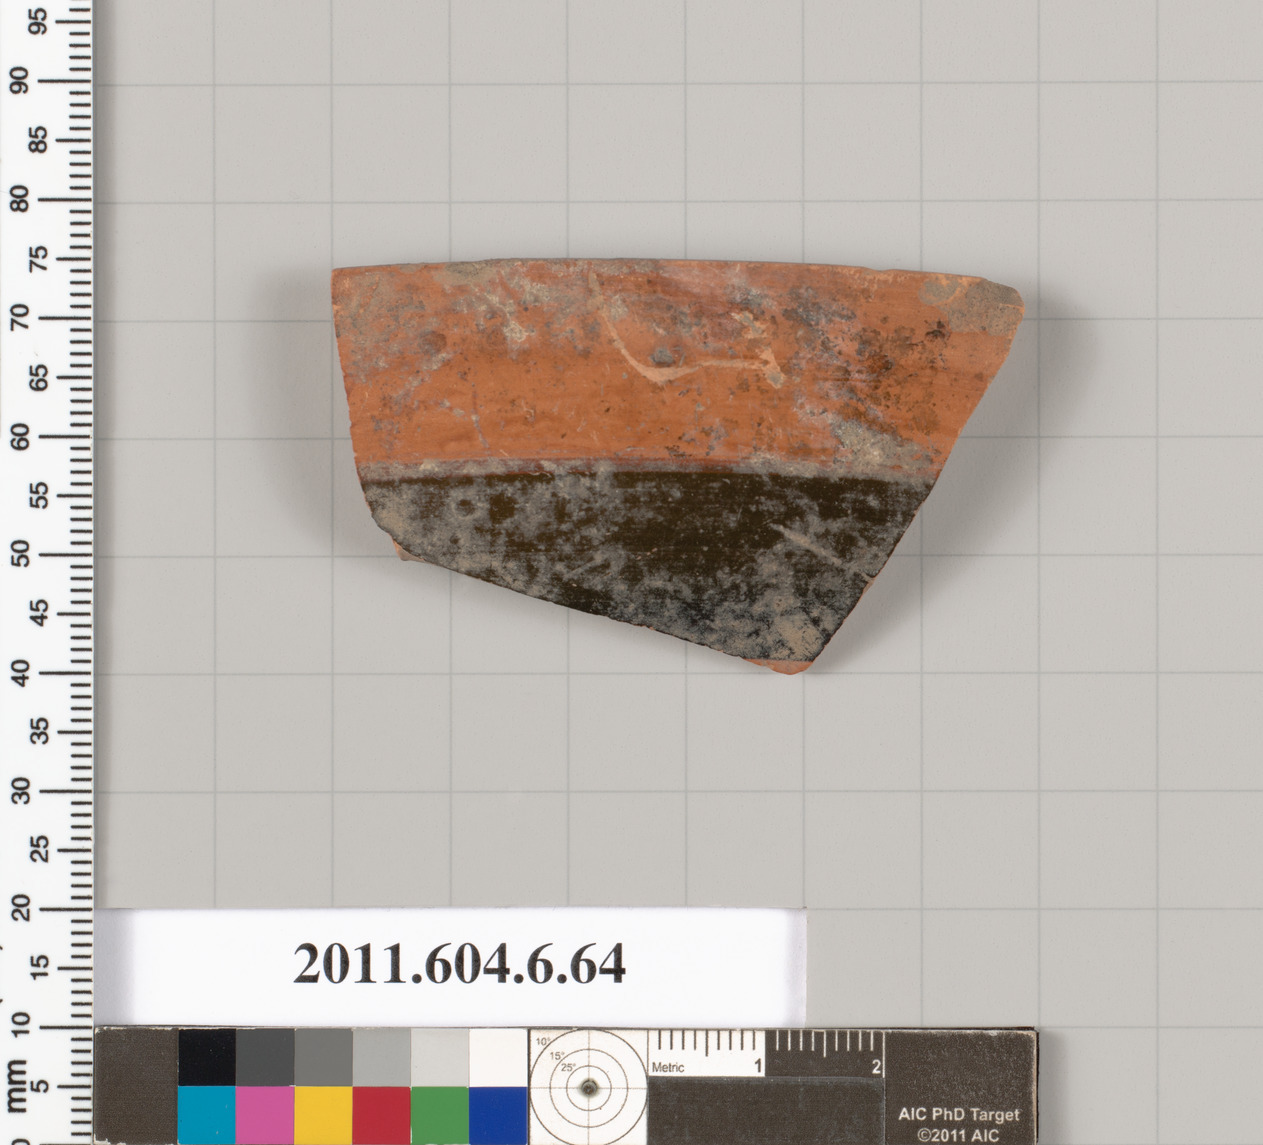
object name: fragment of a bowl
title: Terracotta fragment of a bowl?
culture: greek, attic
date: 600-401 BCE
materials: terracotta